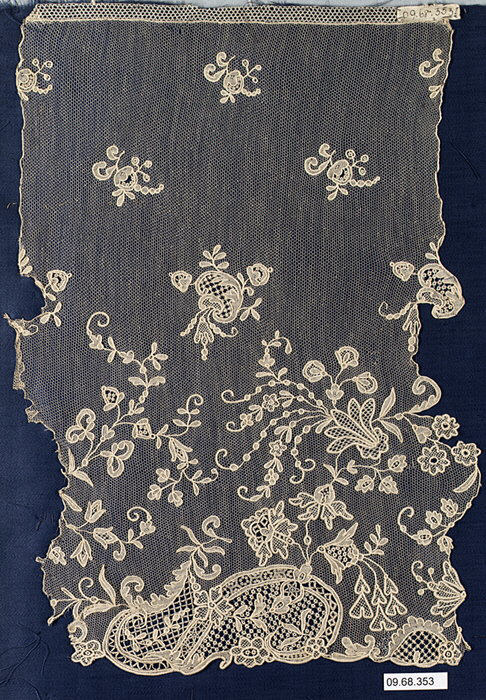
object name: fragment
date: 1801-1900